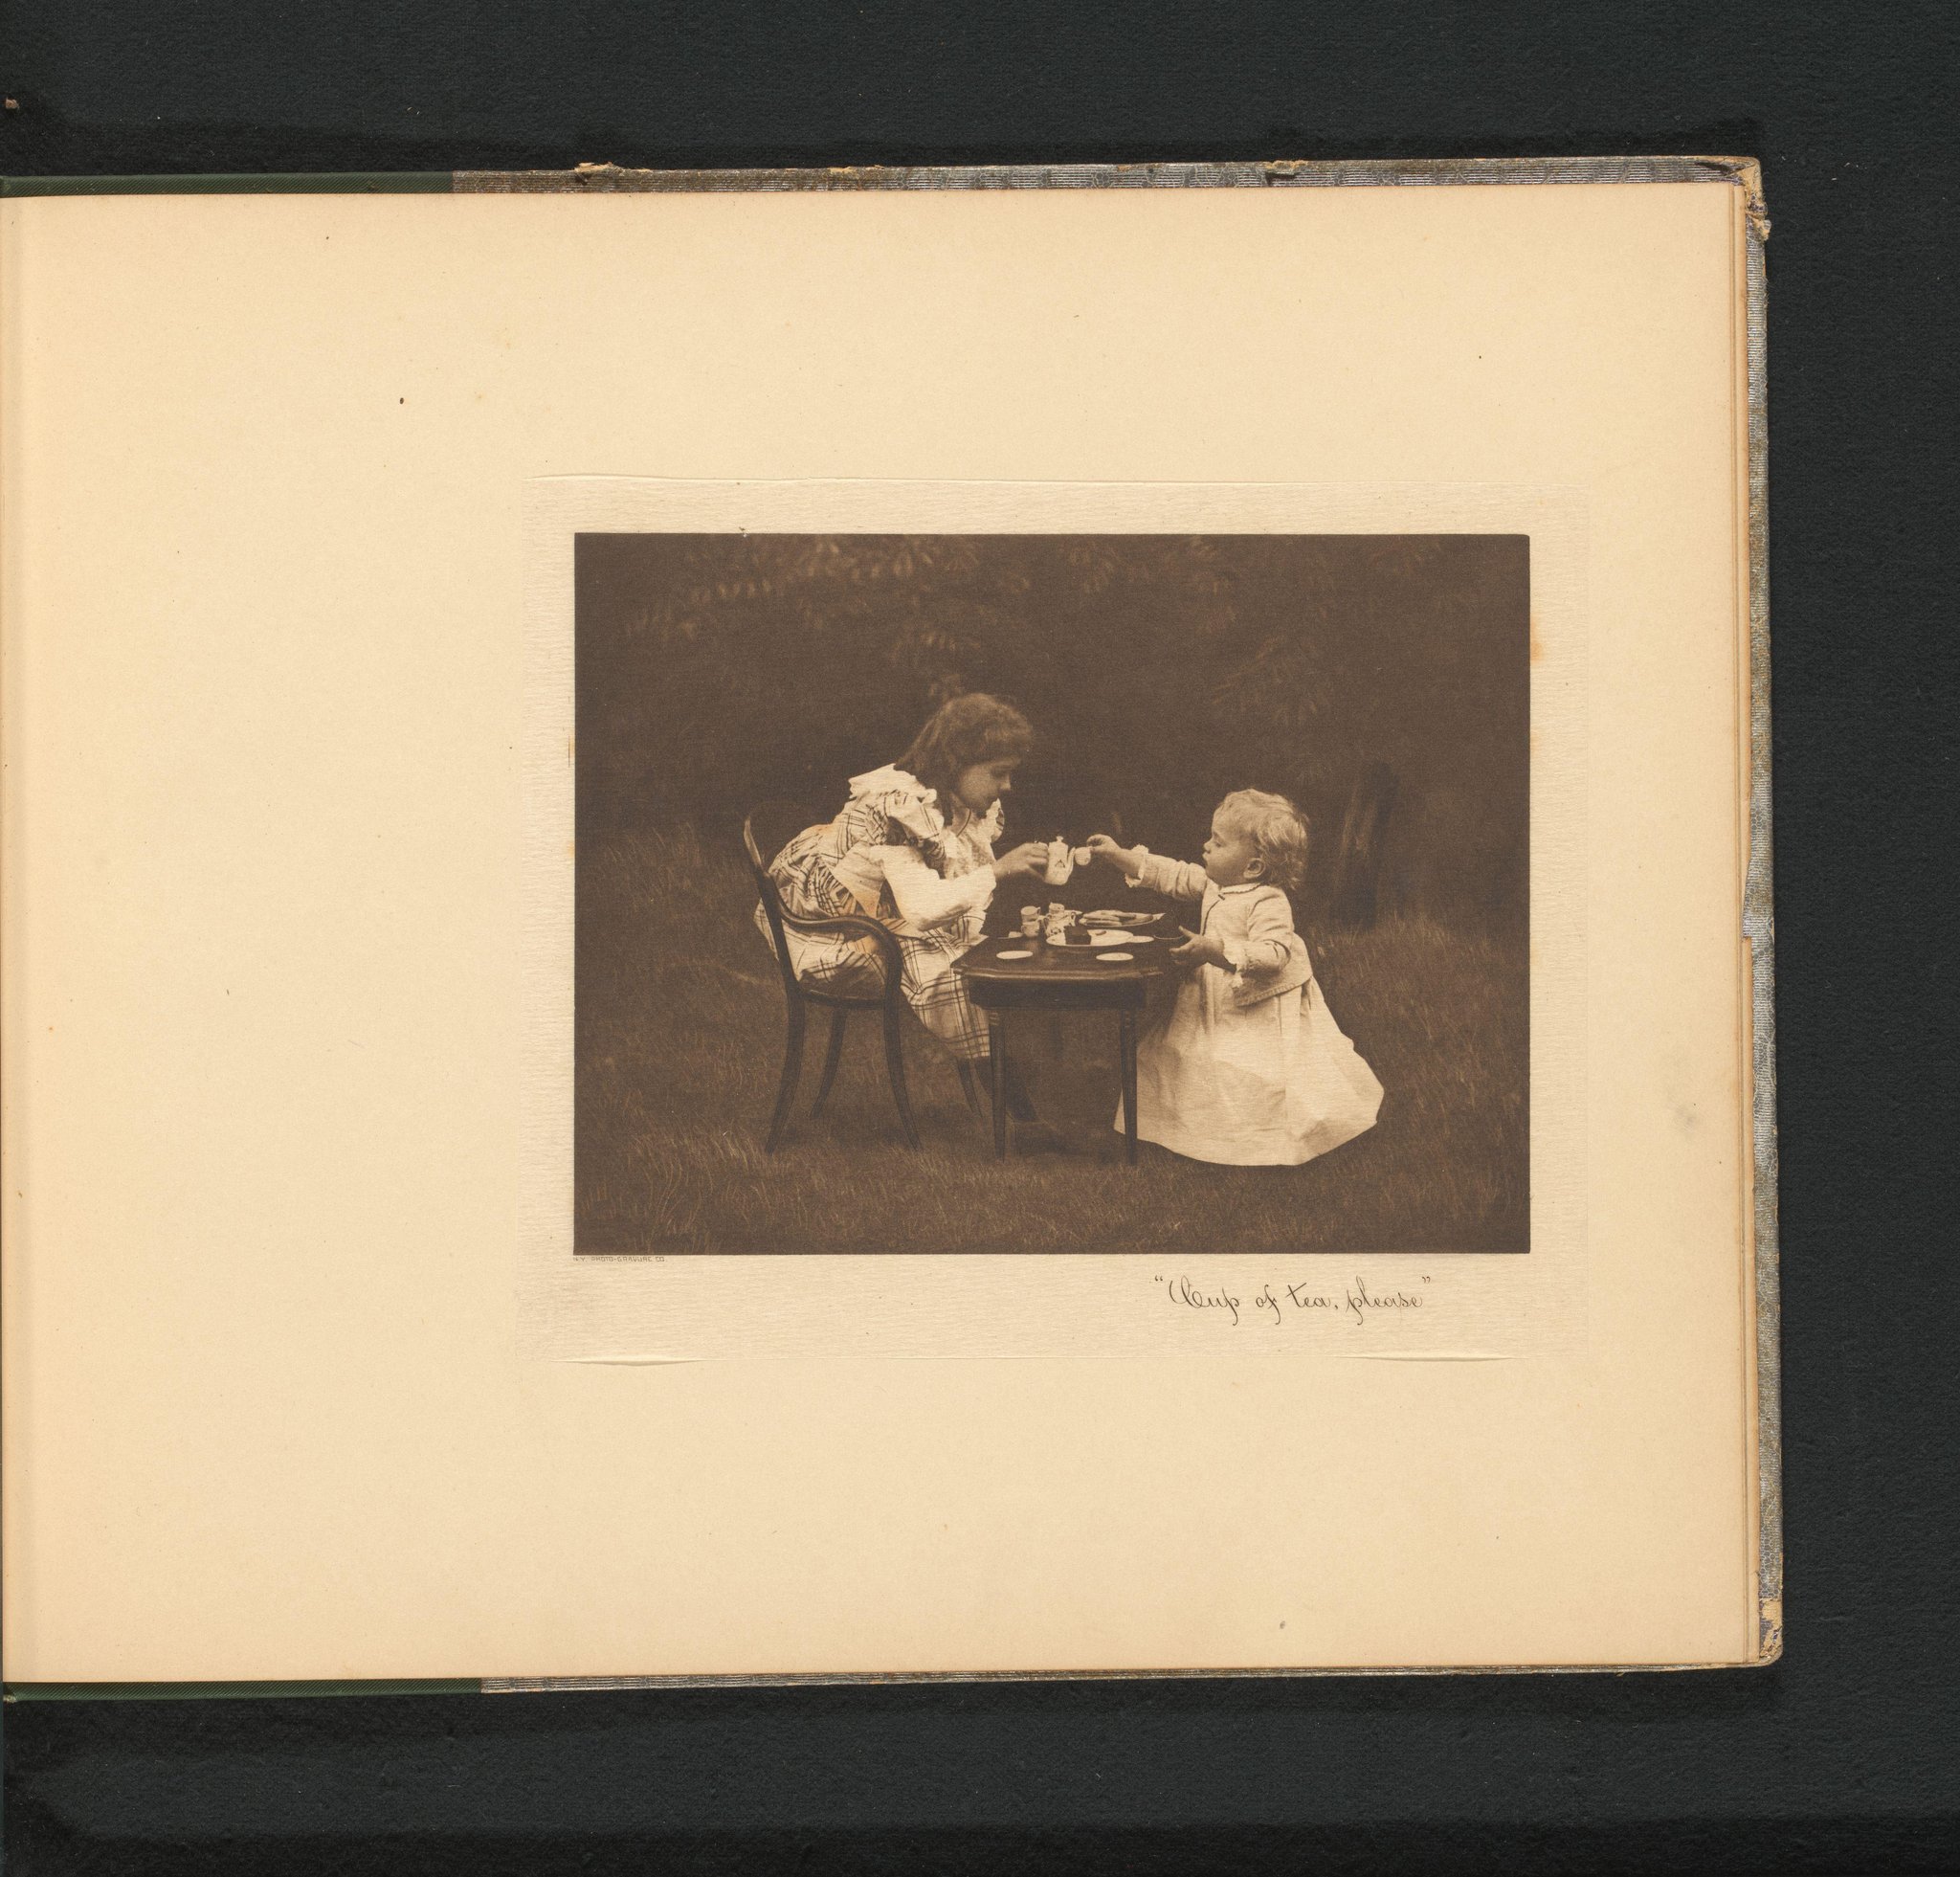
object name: photomechanical print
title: “Cups of tea, please”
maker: walter george mitchell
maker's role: fotograaf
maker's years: 1877-1935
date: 1881-1891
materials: paper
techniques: photoaquatint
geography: new york city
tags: afternoon tea - cc - out of doors, girl (child between toddler and youth)